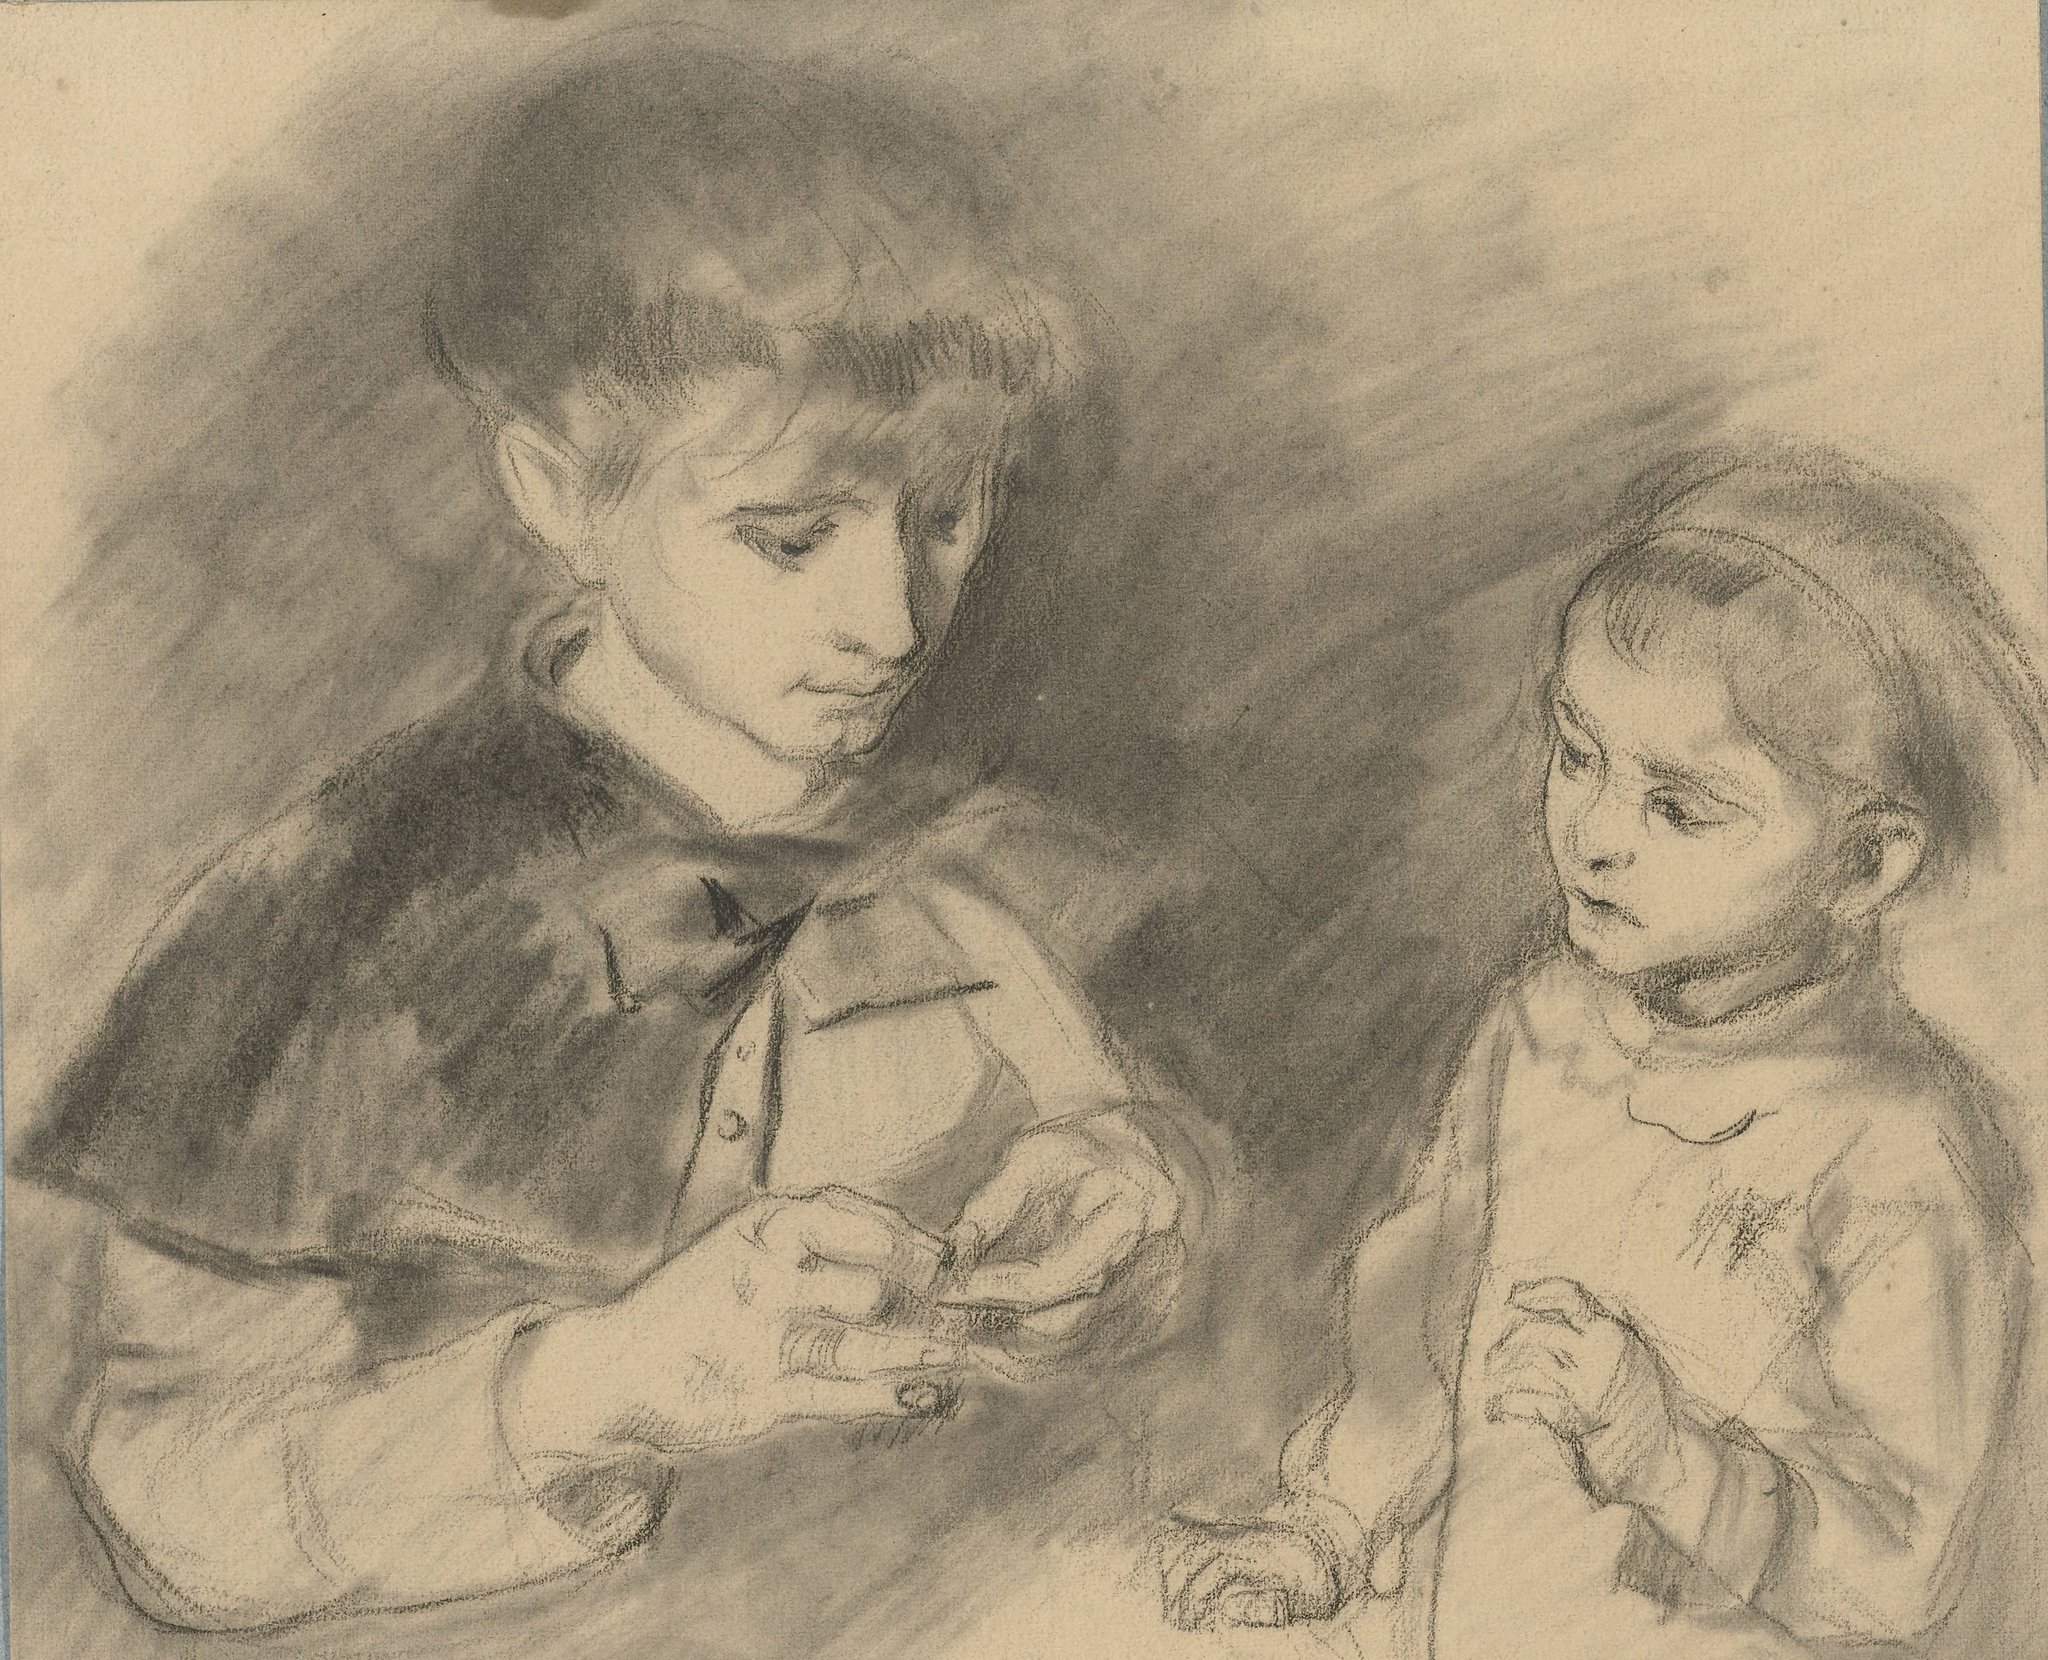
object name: drawing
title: Jongen en meisje, ten halven lijve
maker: adrien emmanuel marie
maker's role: draughtsman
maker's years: 1848-1891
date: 1858-1891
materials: chalk, charcoal, paper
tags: boy (child between toddler and youth), girl (child between toddler and youth)